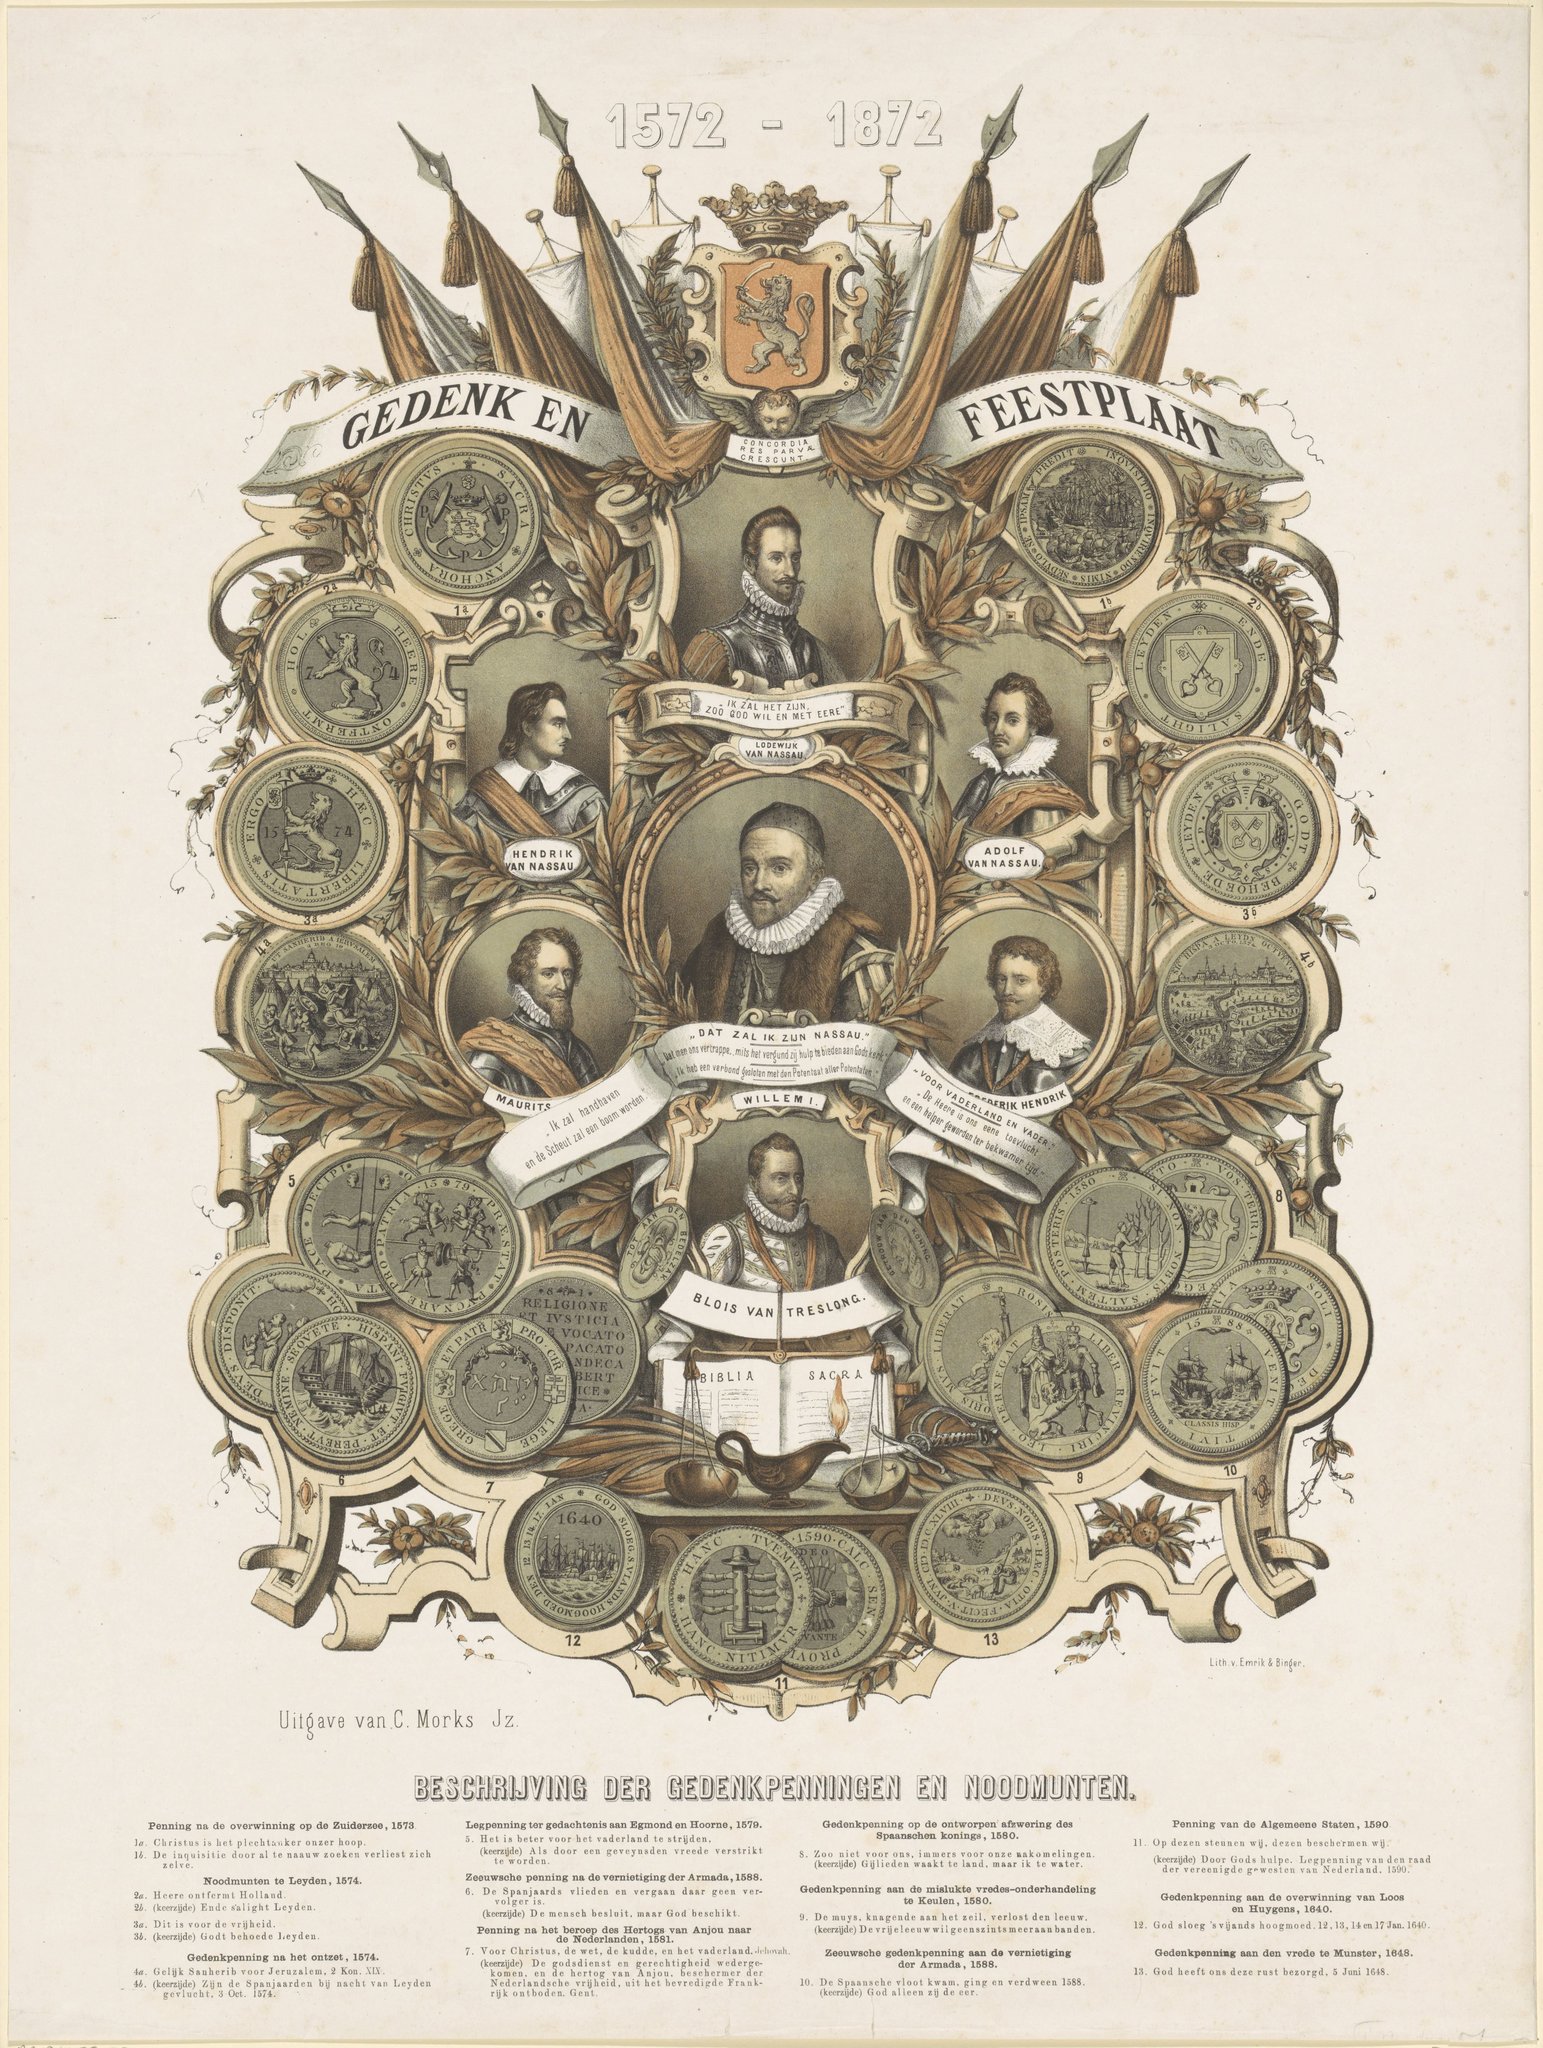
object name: print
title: Gedenk- en feestplaat met portretten van Willem I, prins van Oranje, zijn zoons Maurits en Frederik Hendrik, prinsen van Oranje, zijn broers Lodewijk, Adolf en Hendrik, graven van Nassau, en Willem Bloys van Treslong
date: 1872-1894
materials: paper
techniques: lithograph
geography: dordrecht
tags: frederick henry (prince of orange), william i (prince of orange), the hague, maurice (prince of orange)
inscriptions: collector's mark: Lugt 2233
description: Gedenk- en feestplaat met portretten van Willem I, zijn zoons Maurits en Frederik Hendrik, zijn broers Lodewijk, Adolf en Hendrik, en Willem Bloys van Treslong. Elk in een geornamenteerde omlijsting met hun namen en titels. Daar omheen dertien penningen en een aantal allegorische objecten. Midden boven de jaartallen '1572-1872'. In de ondermarge een verklarende lijst met nummers.